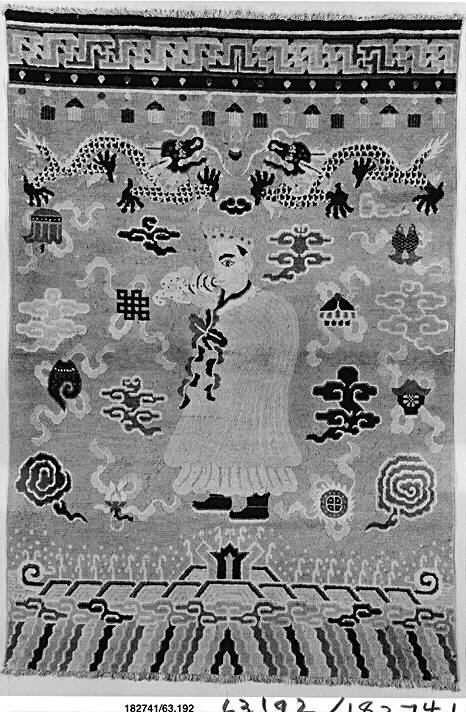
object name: pillar rug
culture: chinese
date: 1801-1900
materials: cotton, wool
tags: men,dragons